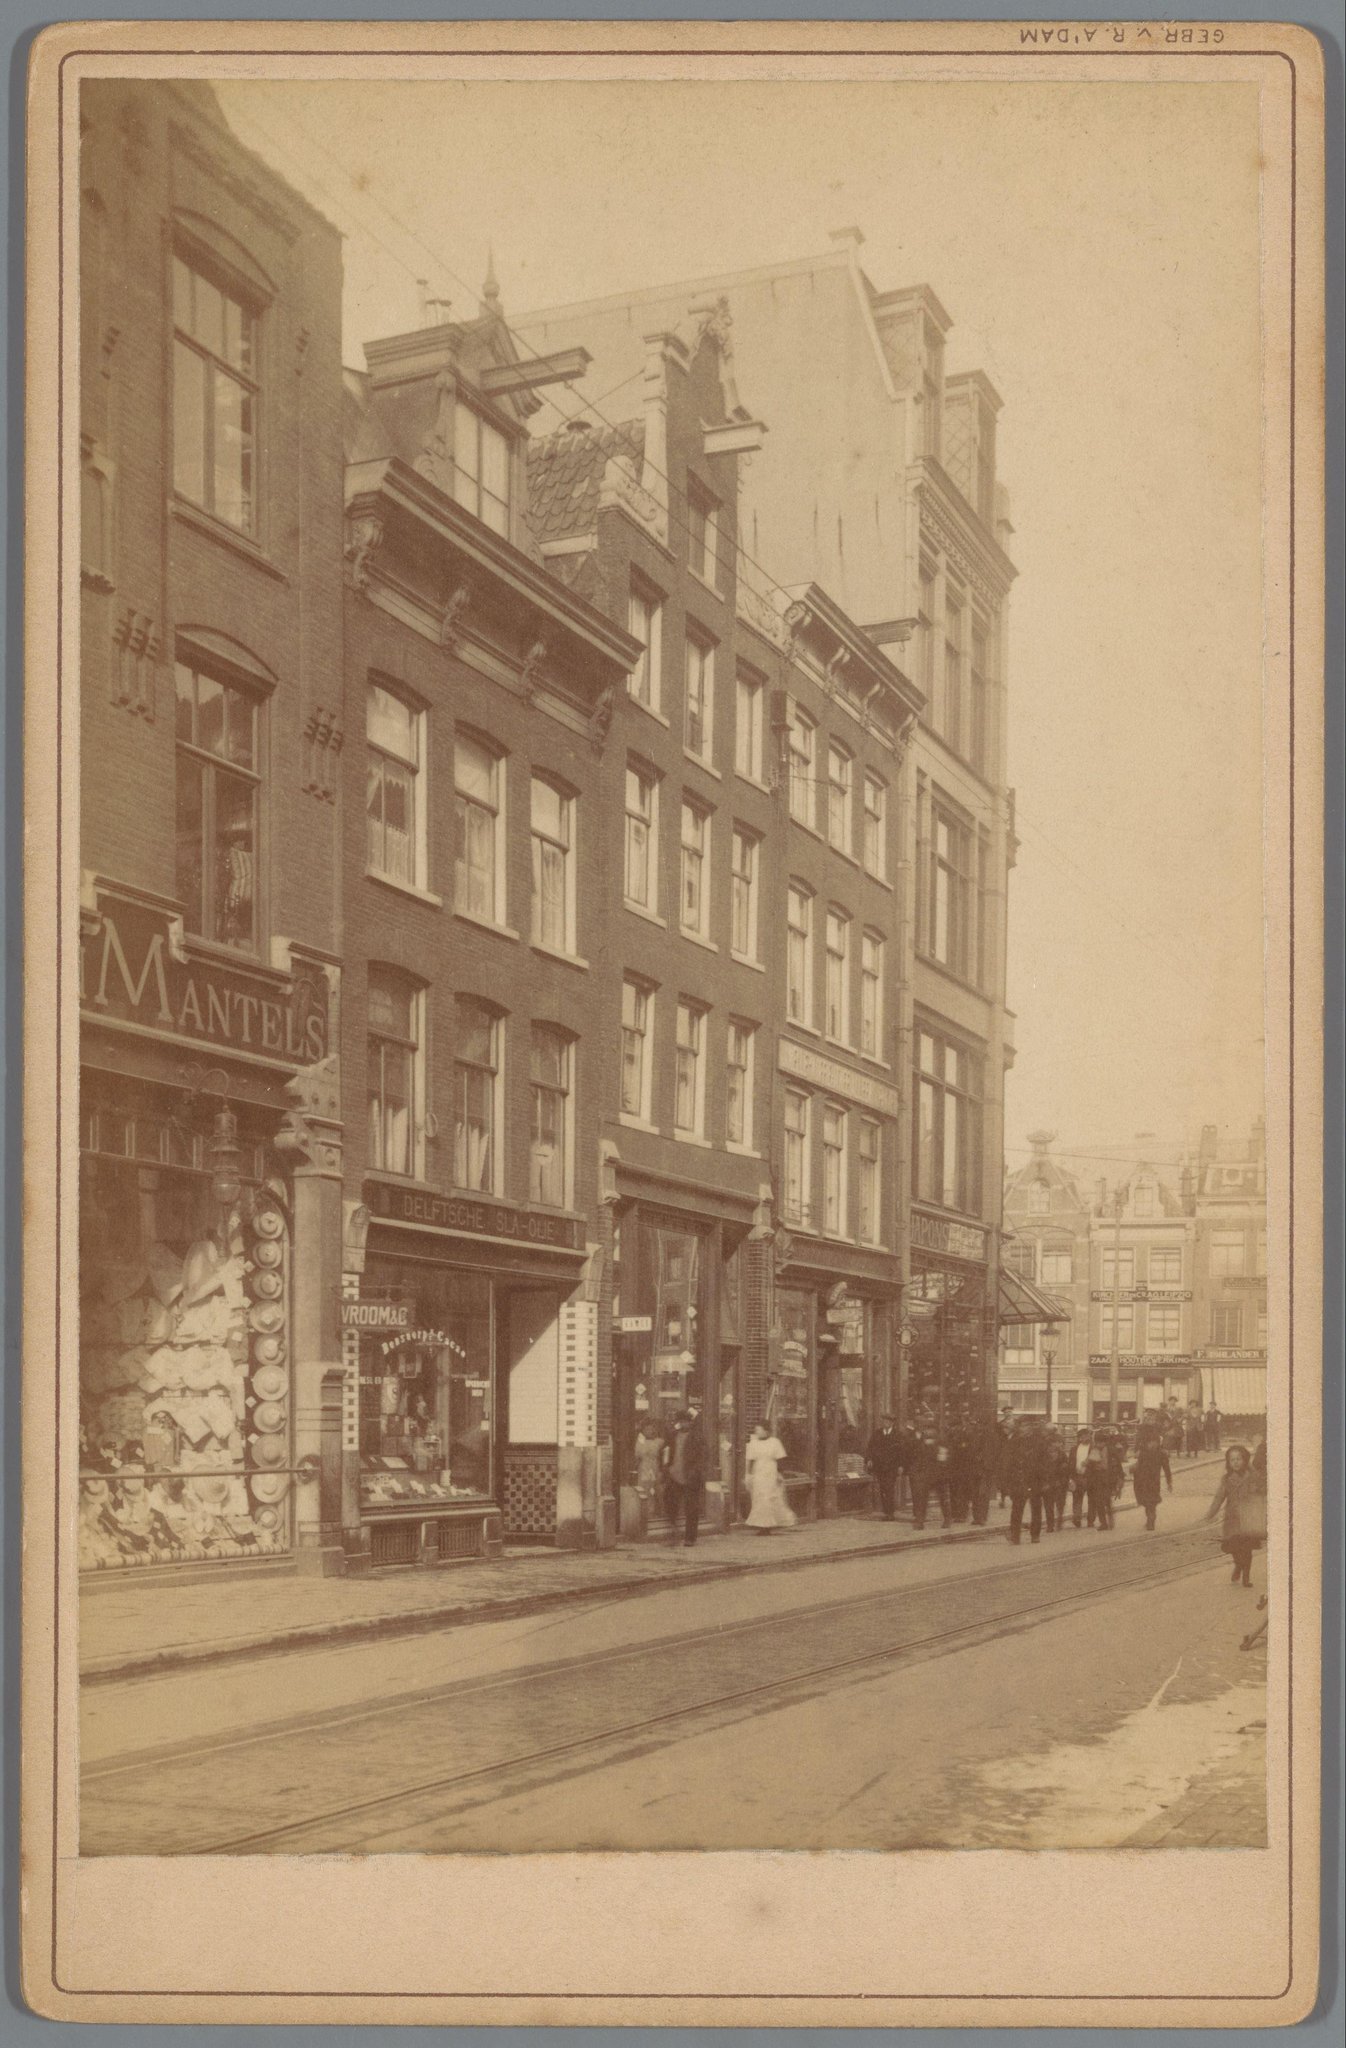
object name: cabinet photograph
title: Gezicht op de Haarlemmerstraat in Amsterdam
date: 1875-1890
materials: cardboard, photographic support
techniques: albumen print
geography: amsterdam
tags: the usual house or row of houses, street, shop-window, show-window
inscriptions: inscription: ‘Haarlemmerstraat bij de Korte Prinsengracht’, number: ‘467’, name: ‘Vosmaer’